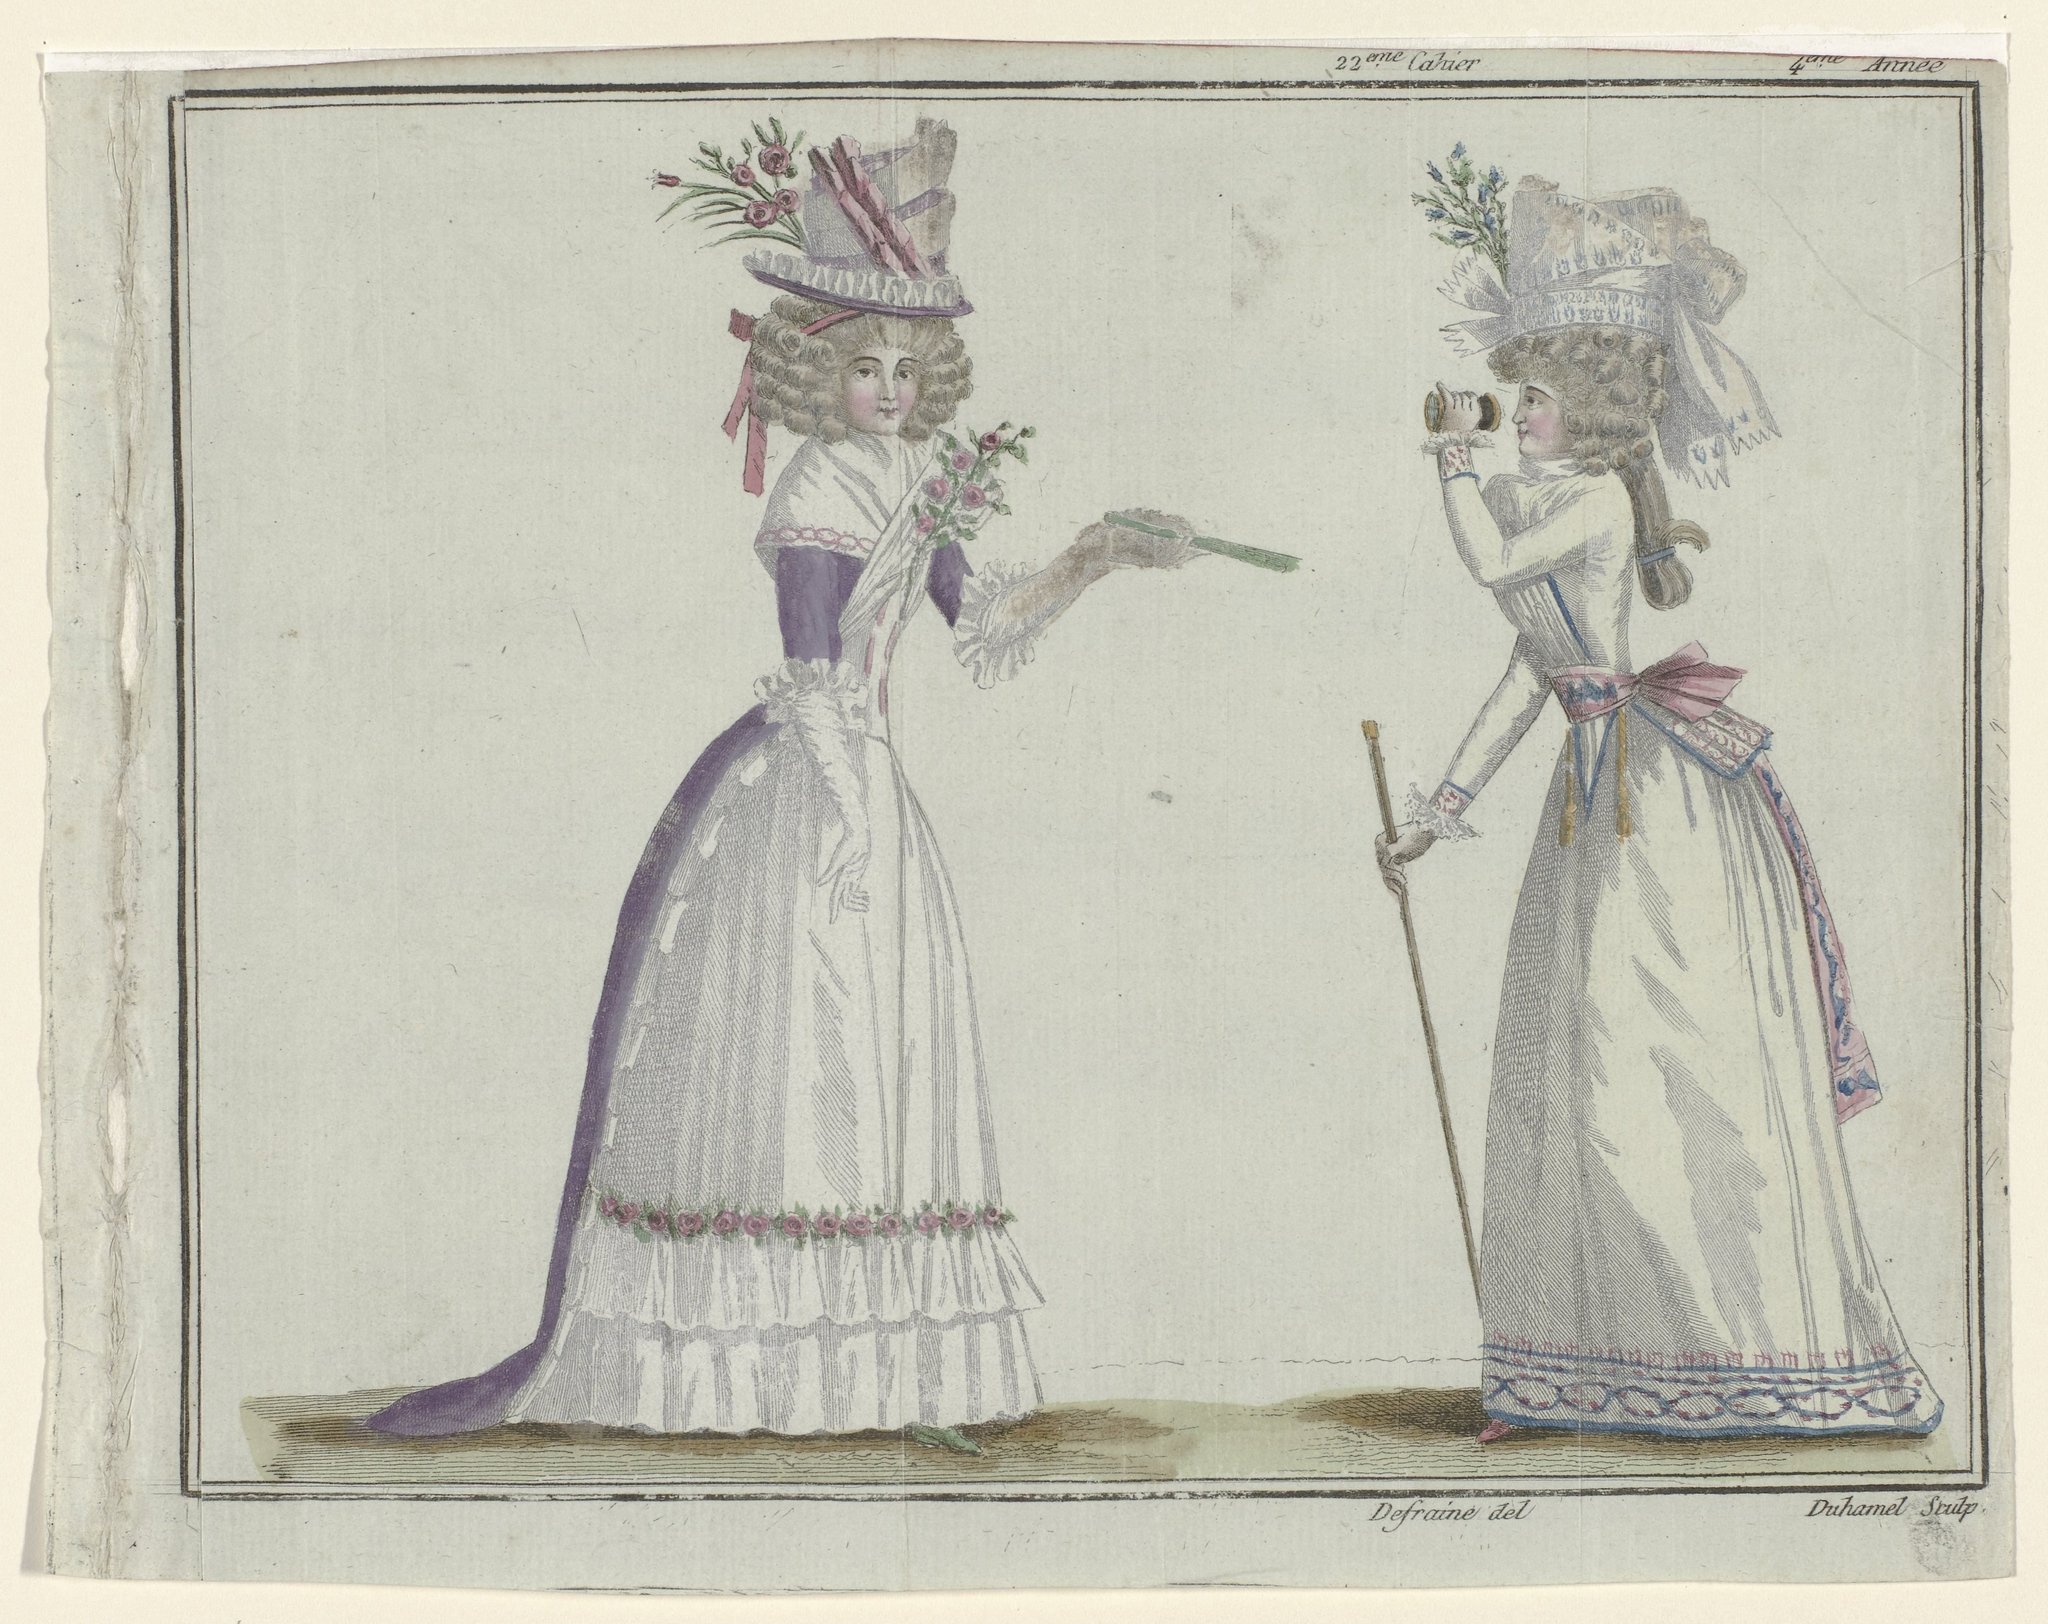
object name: fashion print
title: The First Fashion Magazine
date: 1789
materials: paper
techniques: engraving, hand coloring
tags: clothing for the upper part of the body (caraco) (+ women's clothes), head-gear: cap (+ women's clothes), fashion plates, dress, gown (+ women's clothes)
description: The Cabinet des Modes ou les Modes Nouvelles first appeared on 15 November 1785. As the first real fashion magazine, it was published on a regular basis and wholly dedicated to news from the world of fashion. It was available by subscription only and distributed both in France and abroad. Each eight-page edition contained three hand-coloured engravings. After a year in print, the magazine changed its name to Magasin des Modes Nouvelles Françaises et Anglaises. Instead of three loose sheets, it now included a single fold-out plate depicting clothes and accessories. Publication of the Magasin ceased abruptly in 1789; after this, it was most likely succeeded by the Journal de la Mode et du Goût.